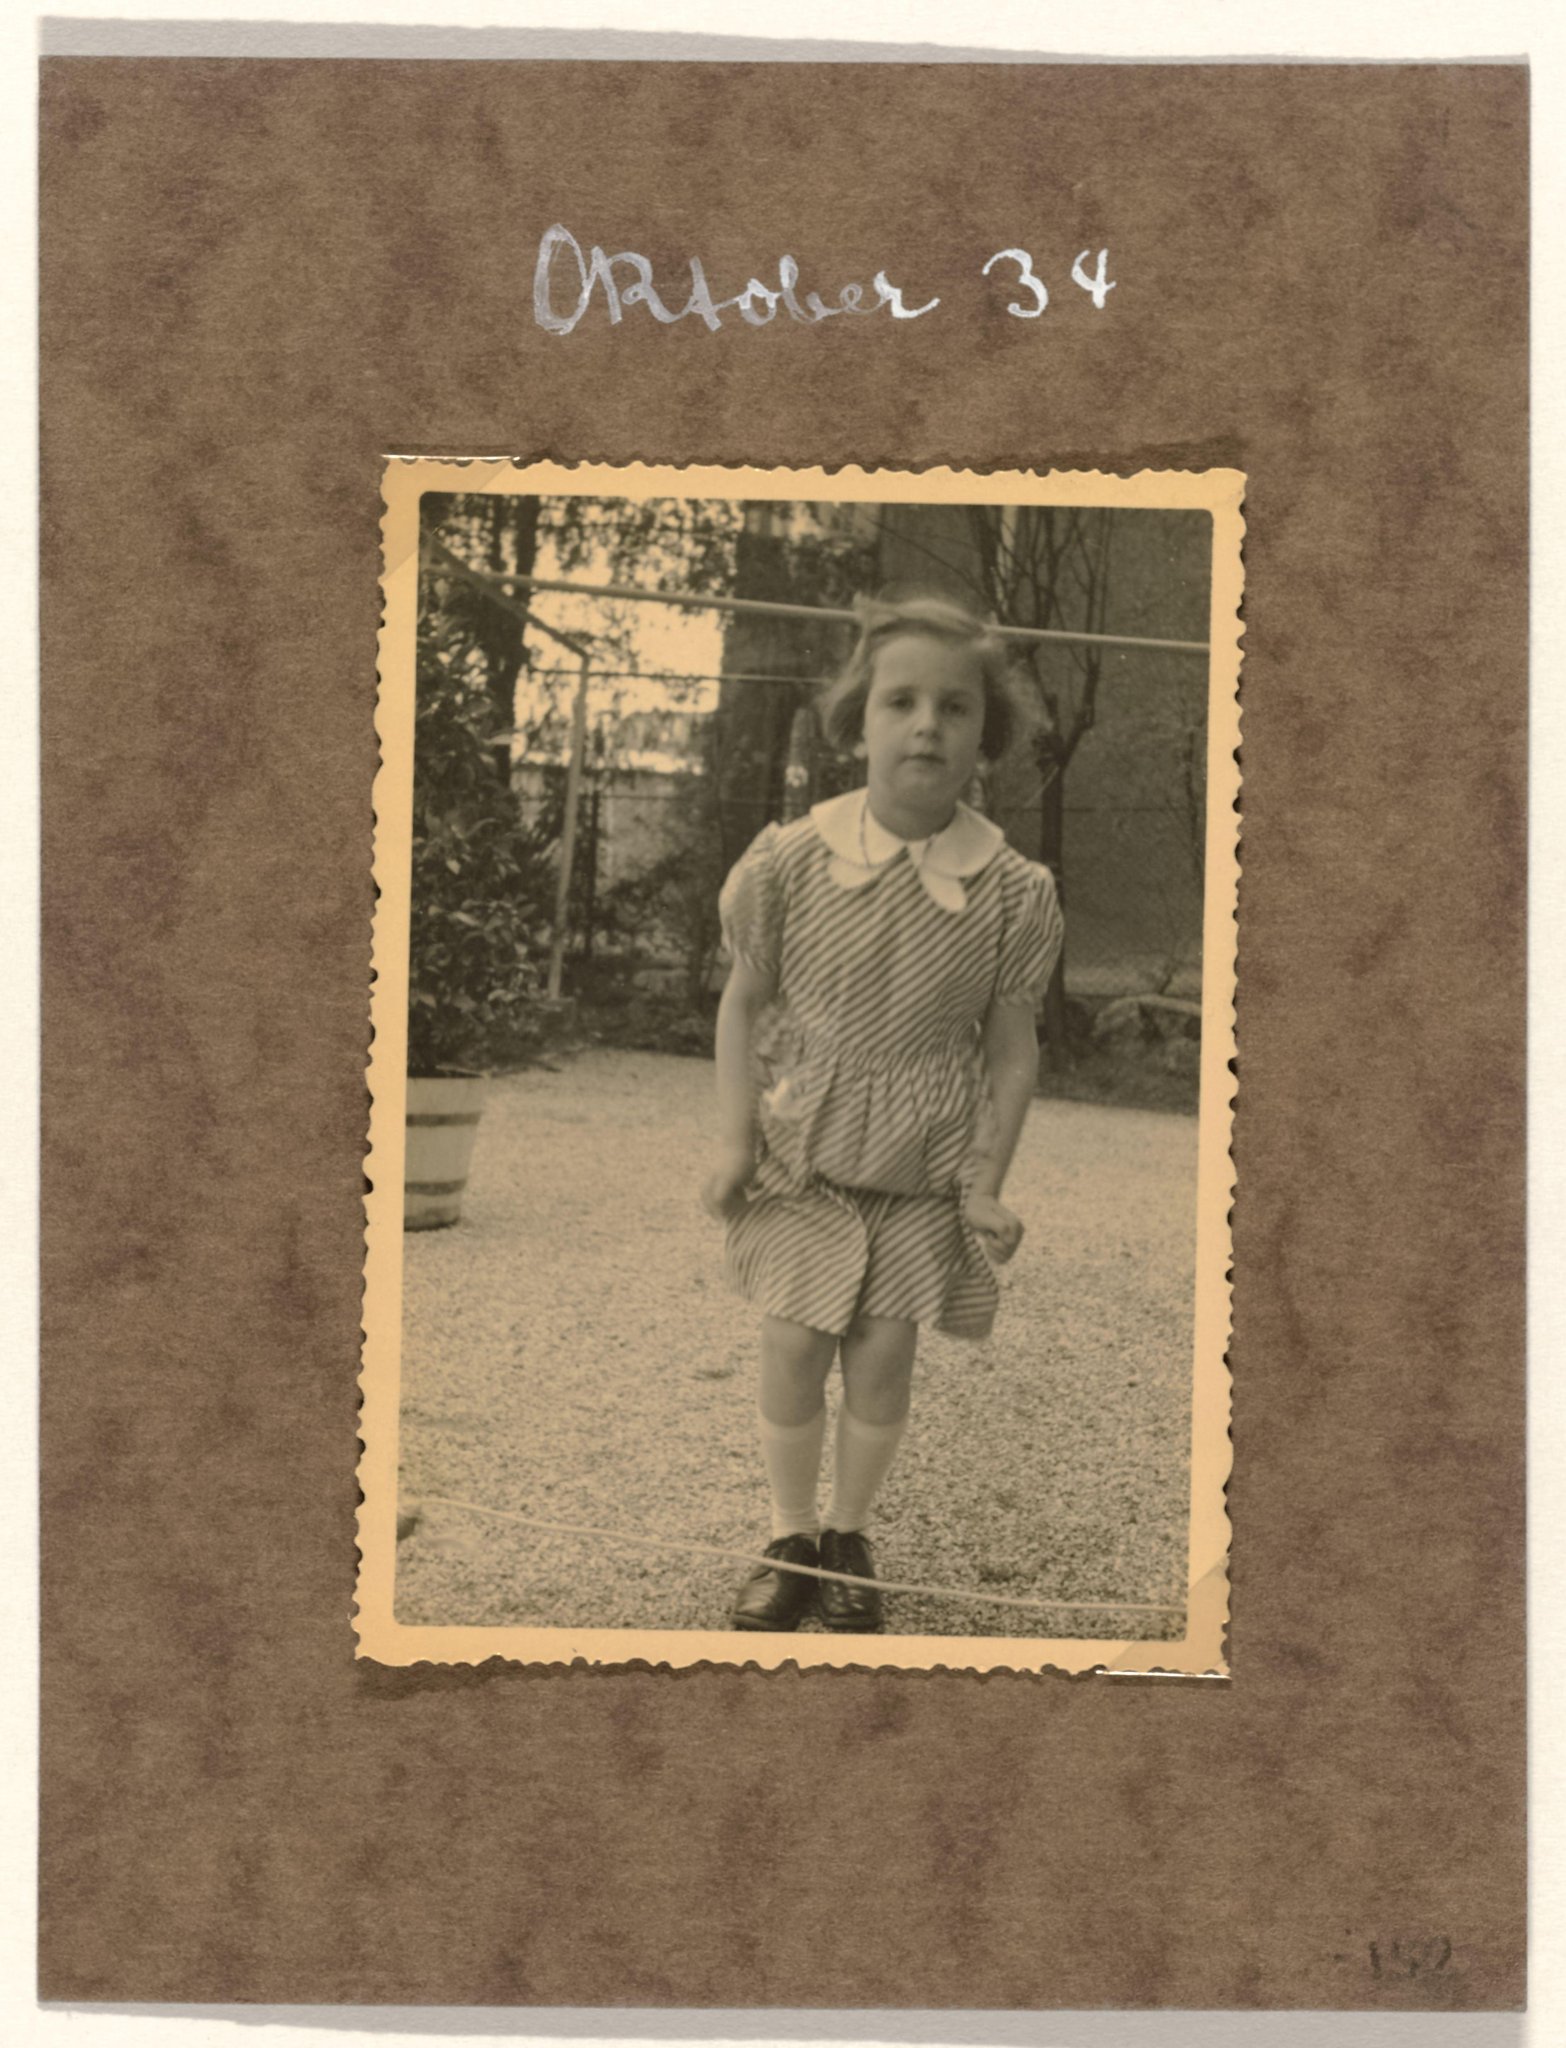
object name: photograph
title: Isabel Wachenheimer in gestreepte jurk voor huizenrij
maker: Anonymous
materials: photographic support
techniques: gelatin silver print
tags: isabel wachenheimer-elon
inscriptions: date: ‘Oktober 34’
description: Isabel Wachenheimer in gestreepte jurk voor huizenrij.